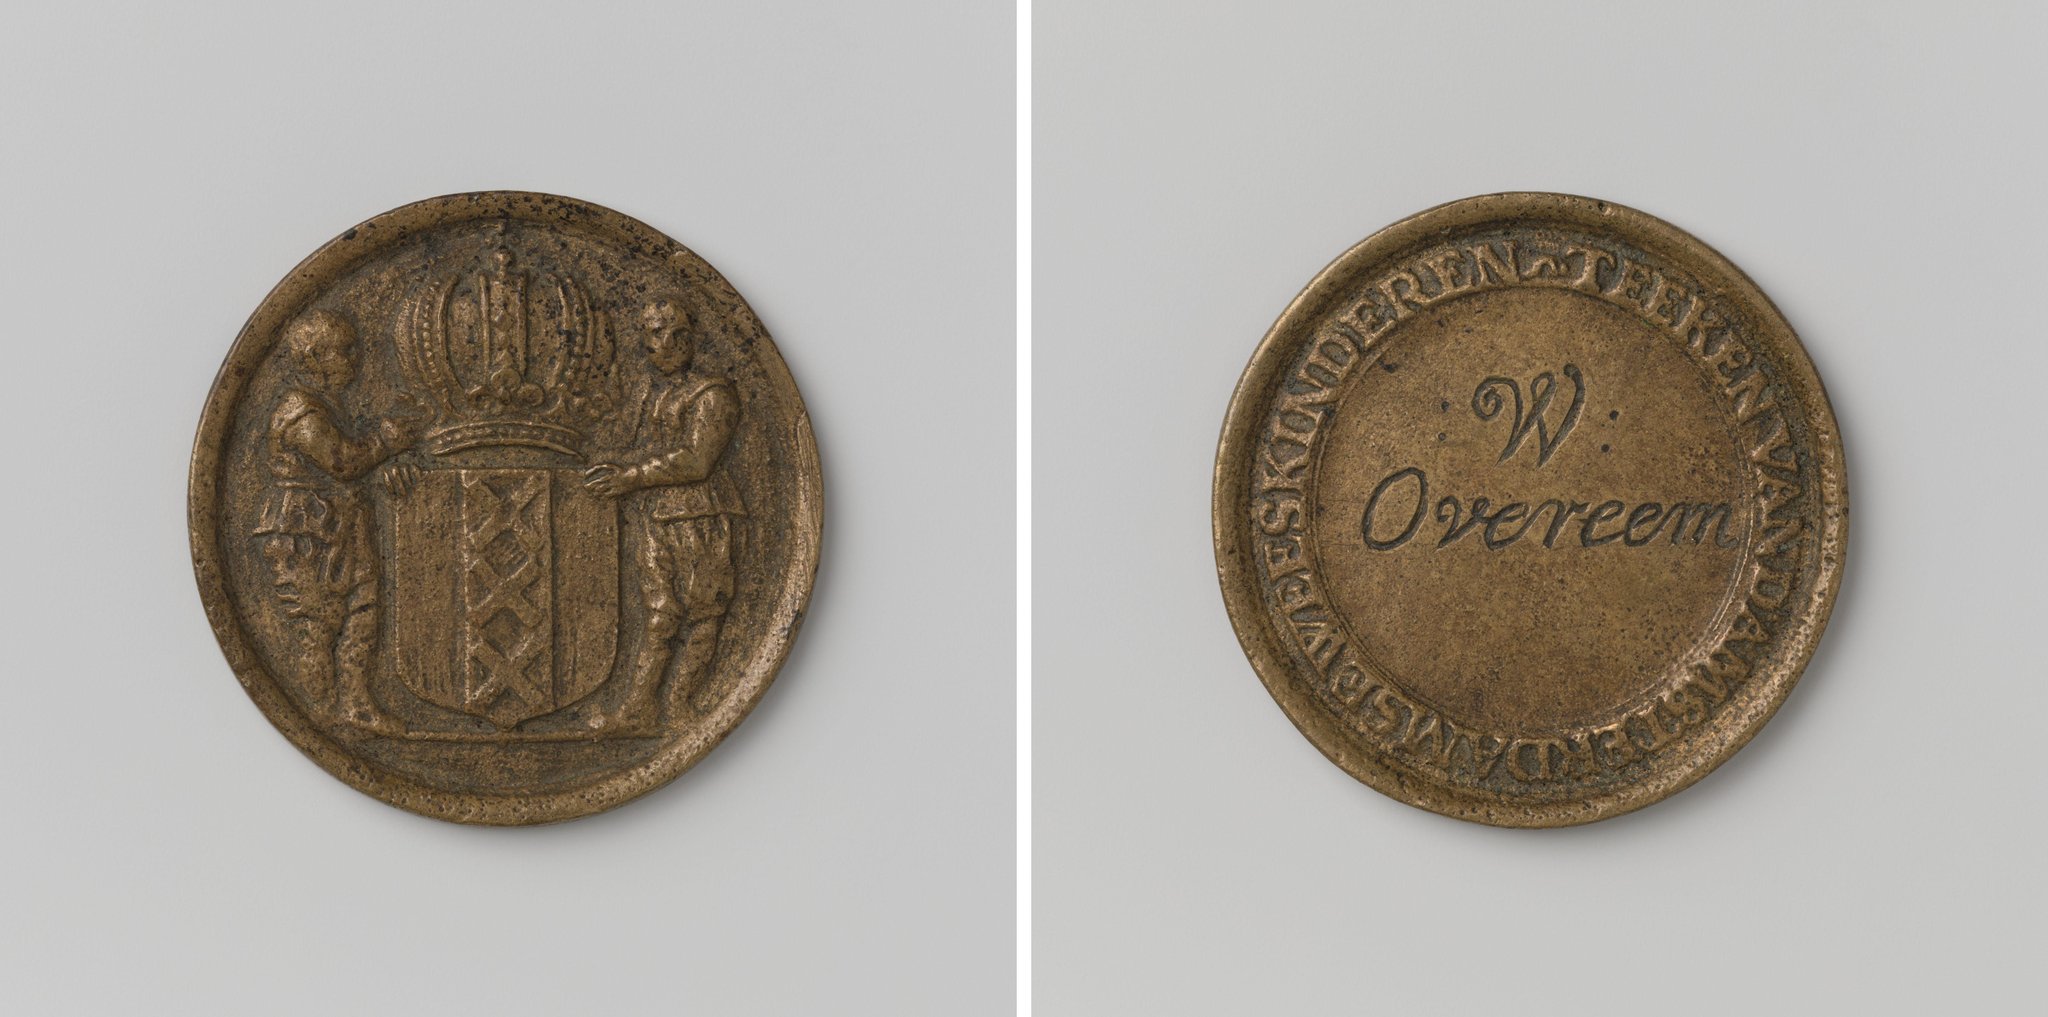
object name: medal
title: Burgerweeshuis te Amsterdam, penning om uit te mogen gaan op naam van W. Overeem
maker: Anonymous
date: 1580-1800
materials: brass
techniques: casting, engraving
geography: amsterdam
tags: w. overeem, burgerweeshuis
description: Messing penning. Voorzijde: gekroond wapenschild, geflankeerd door twee weeskinderen. Keerzijde: opschrift binnen omschrift